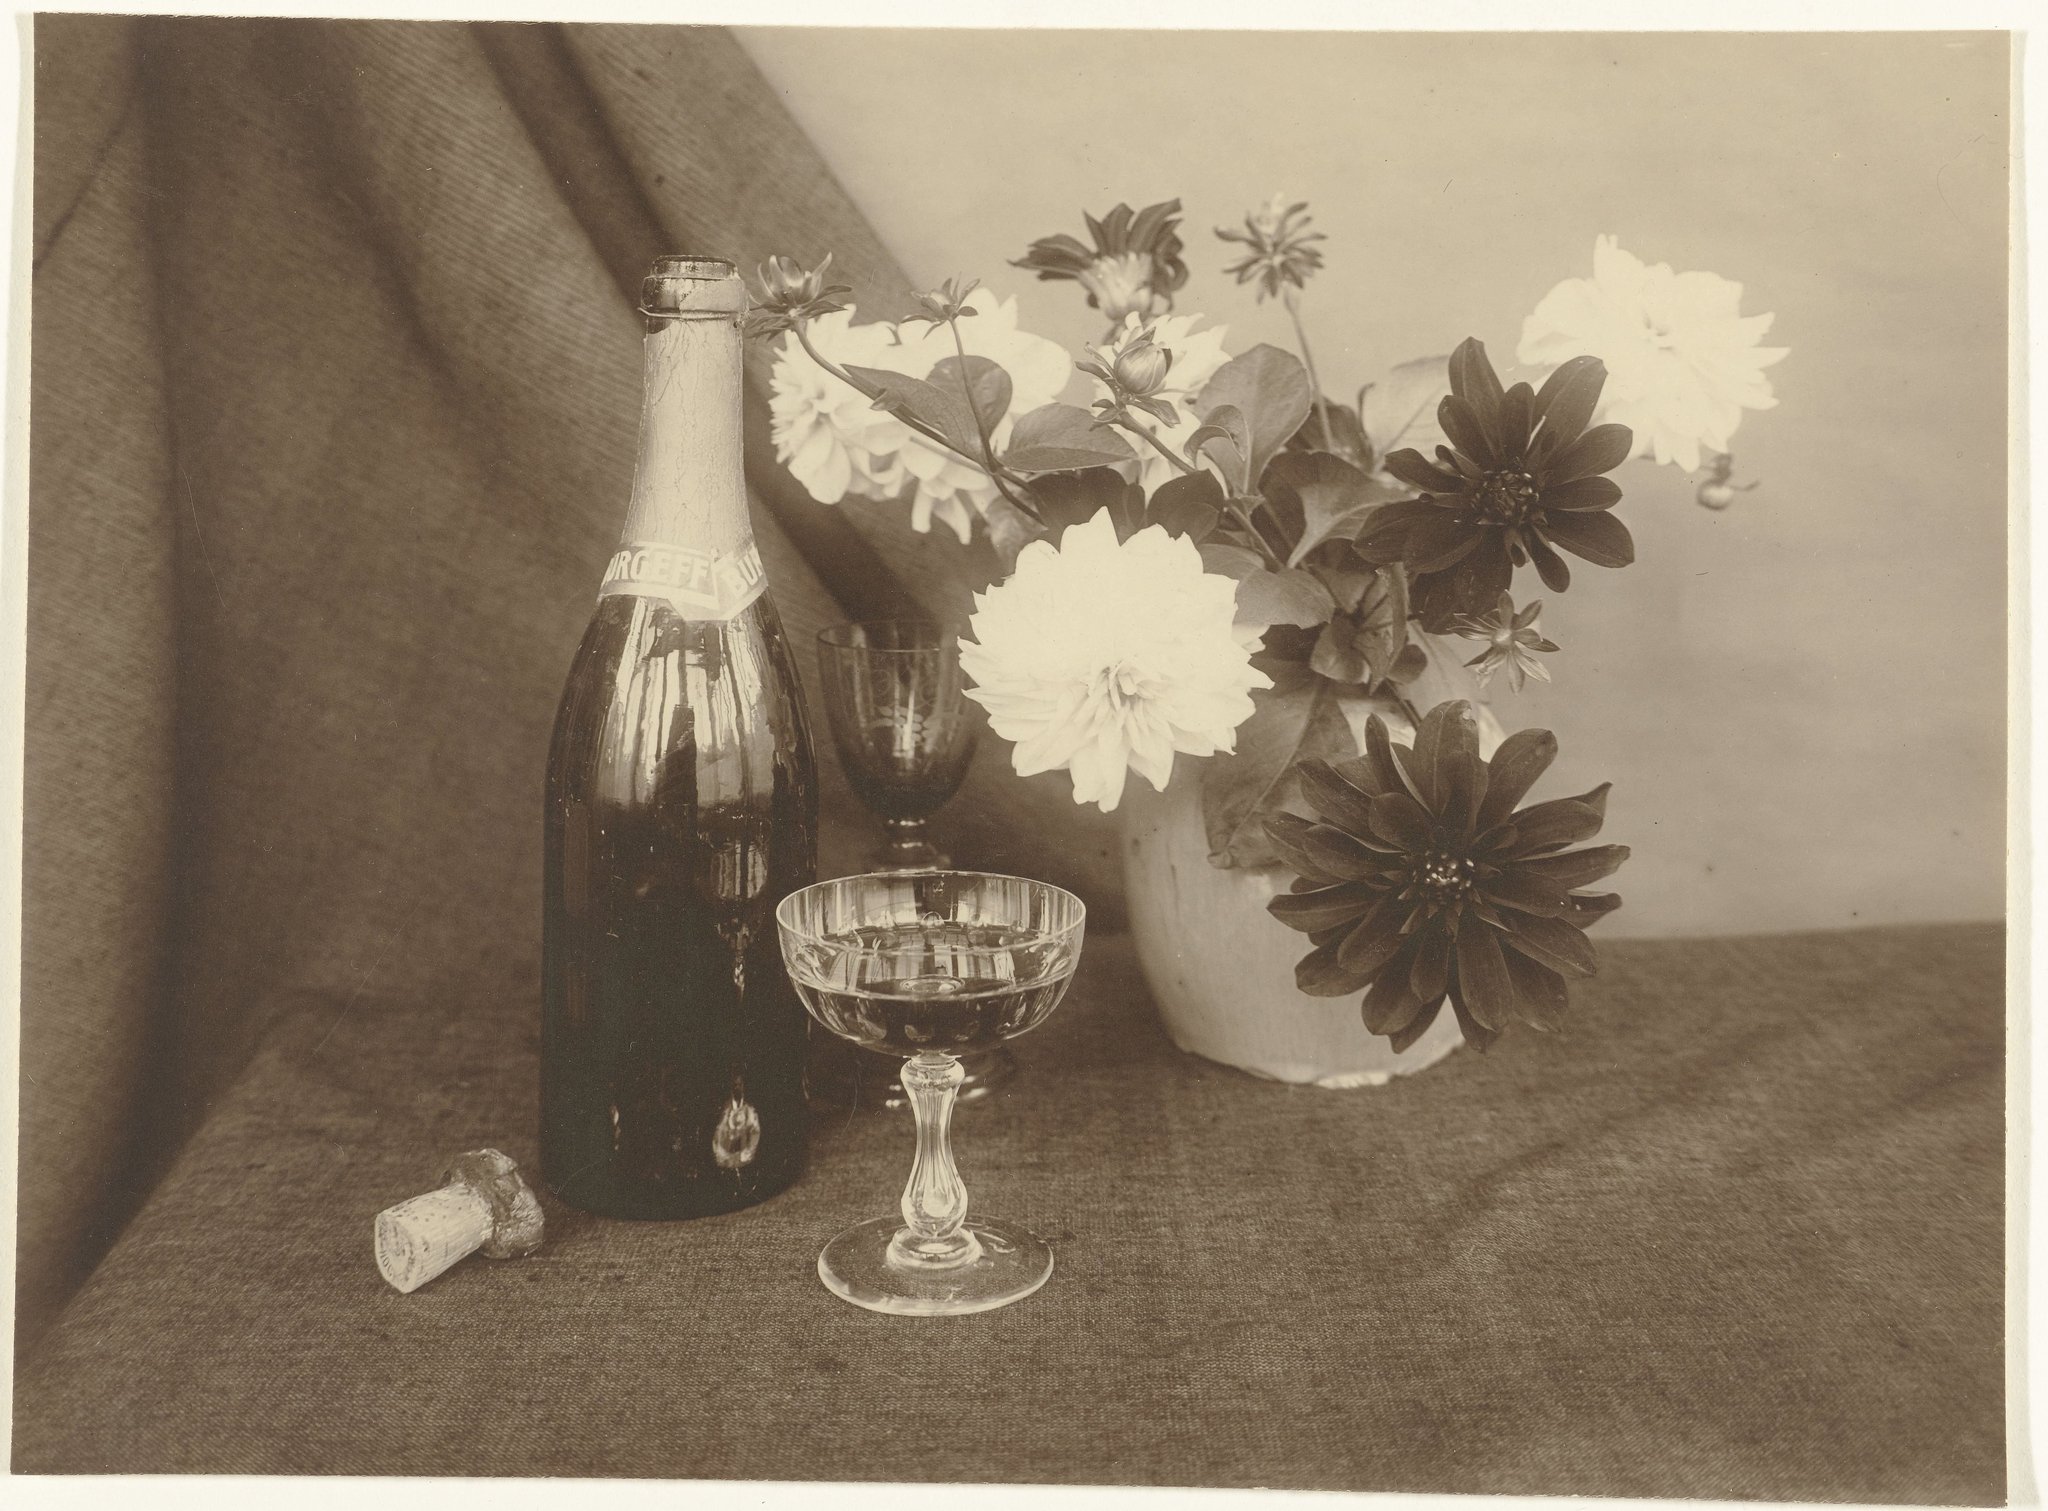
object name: photograph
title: Stilleven met bloemen, champagnefles en glazen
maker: richard tepe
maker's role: fotograaf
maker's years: 1864-1952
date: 1900-1930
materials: paper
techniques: gelatin silver print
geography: netherlands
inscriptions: annotation: ‘TEPE’